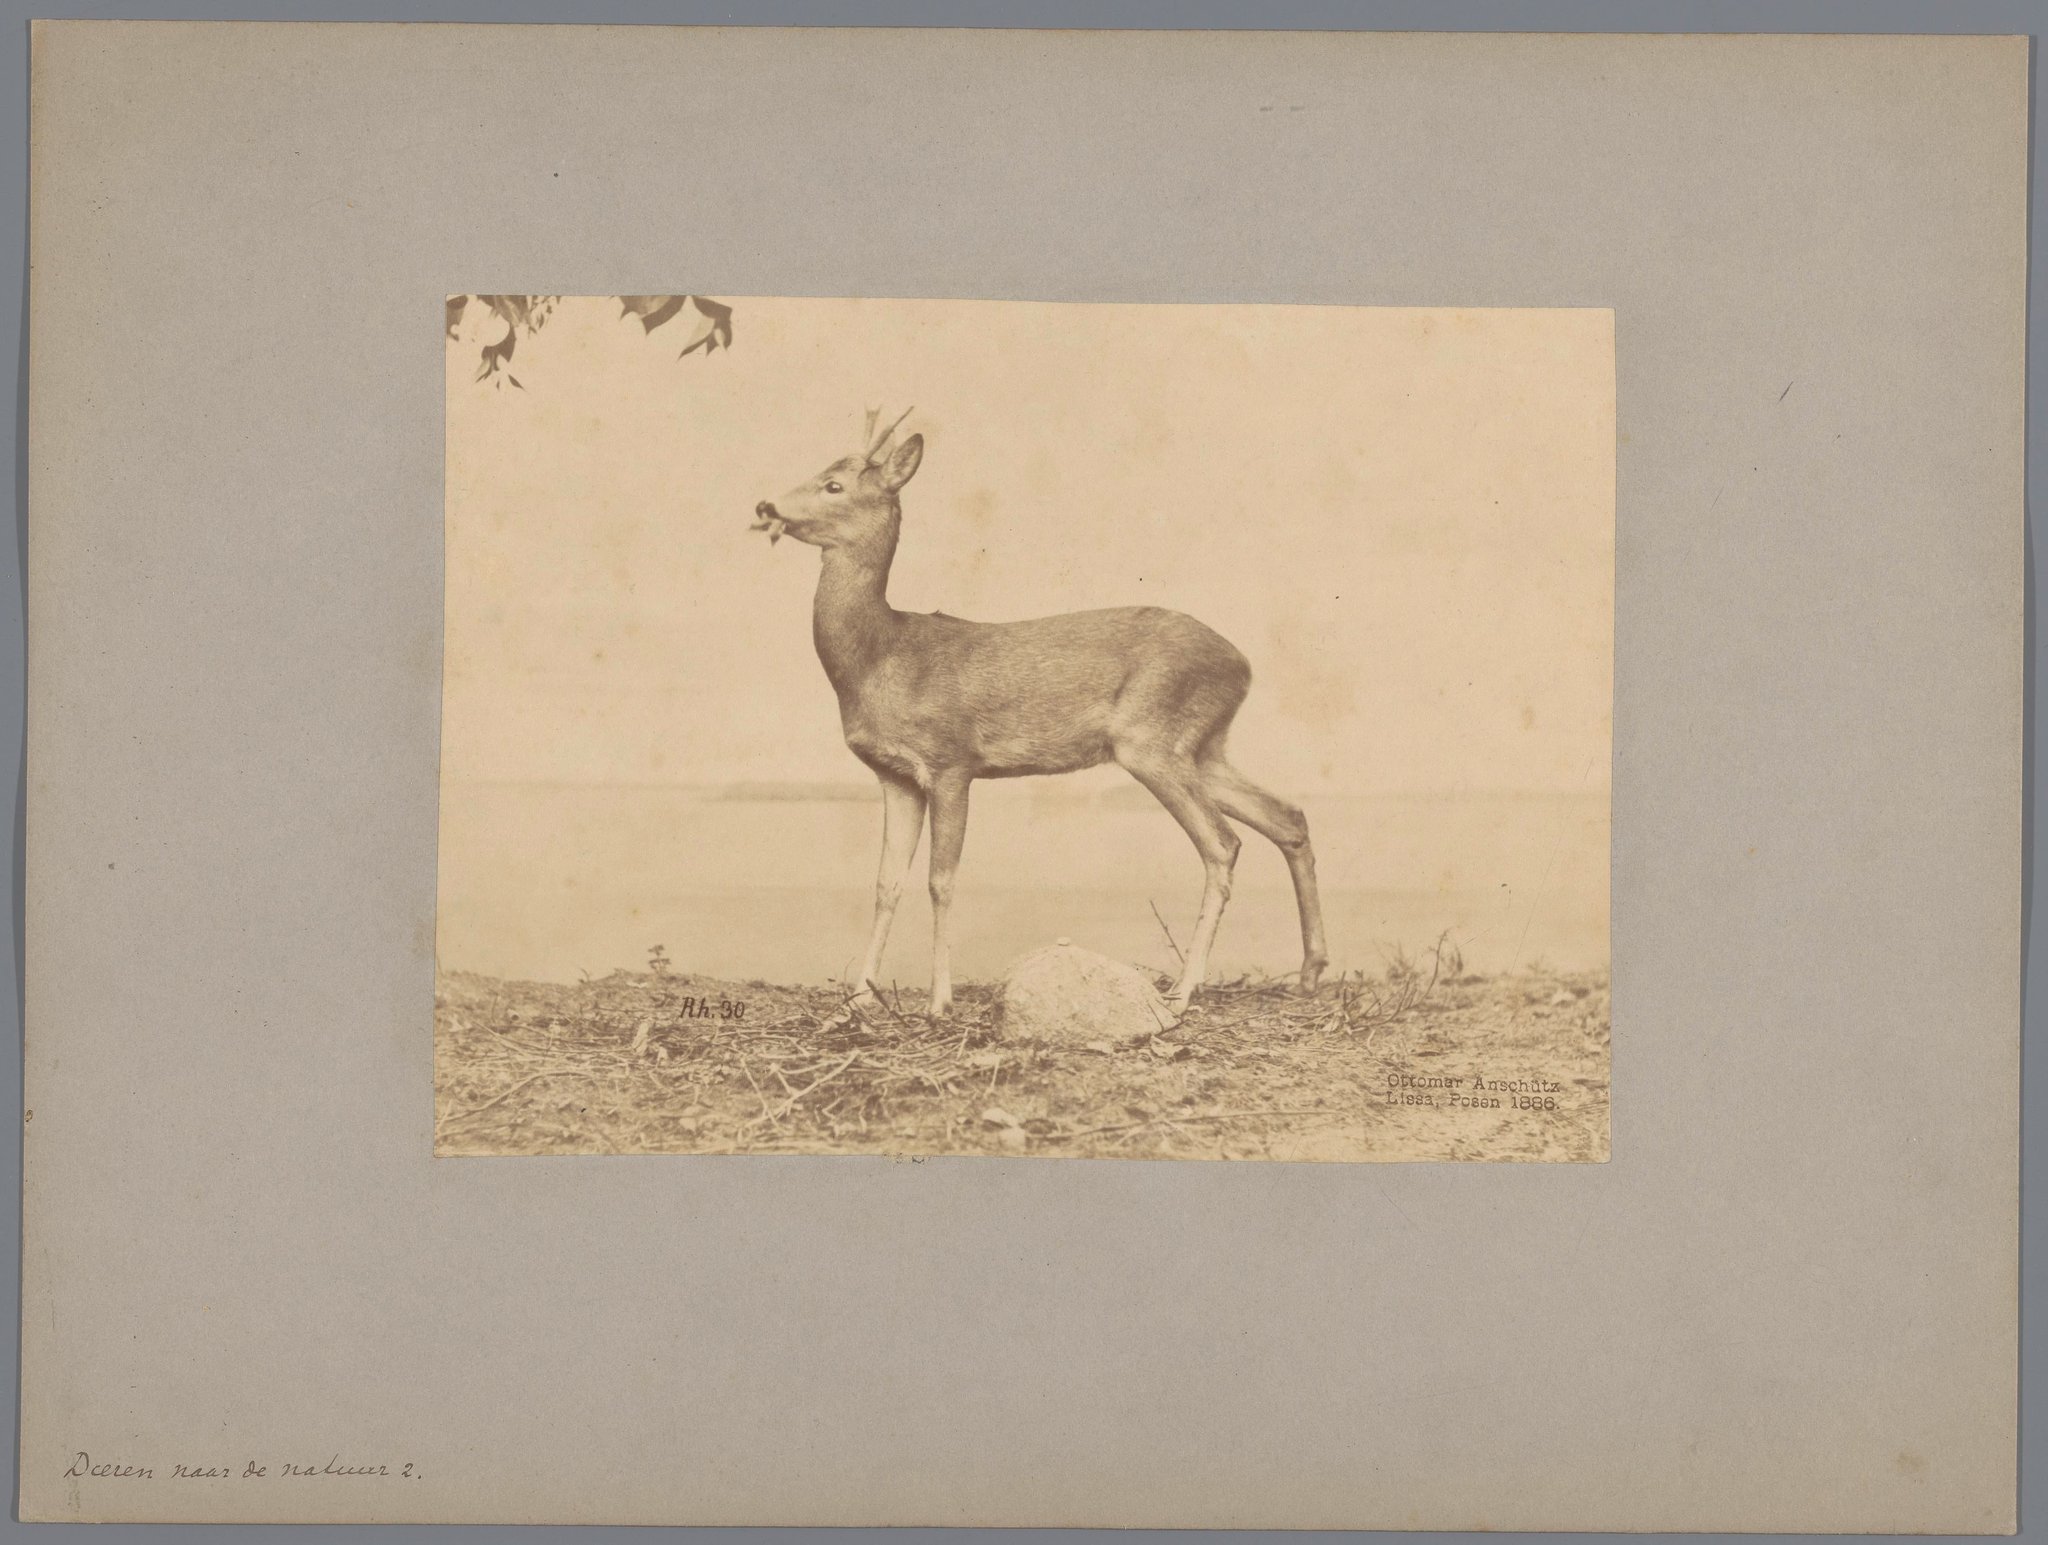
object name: photograph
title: Ree met bladeren in de bek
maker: ottomar anschütz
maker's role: fotograaf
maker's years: 1846-1907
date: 1886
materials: cardboard, photographic support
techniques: albumen print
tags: hoofed animals: deer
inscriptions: name: ‘Ottomar Anschütz Lissa, Posen 1886.’, number: ‘RH. 30’, collector's mark: ‘RIJKS-NORMAALSCHOOL-VOOR-TEEKENONDERWIJZERS-AMSTERDAM’